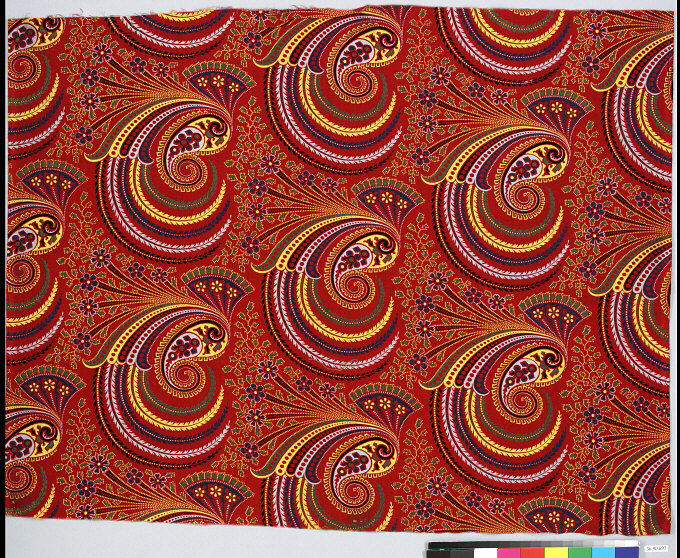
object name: piece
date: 1867-1900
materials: cotton